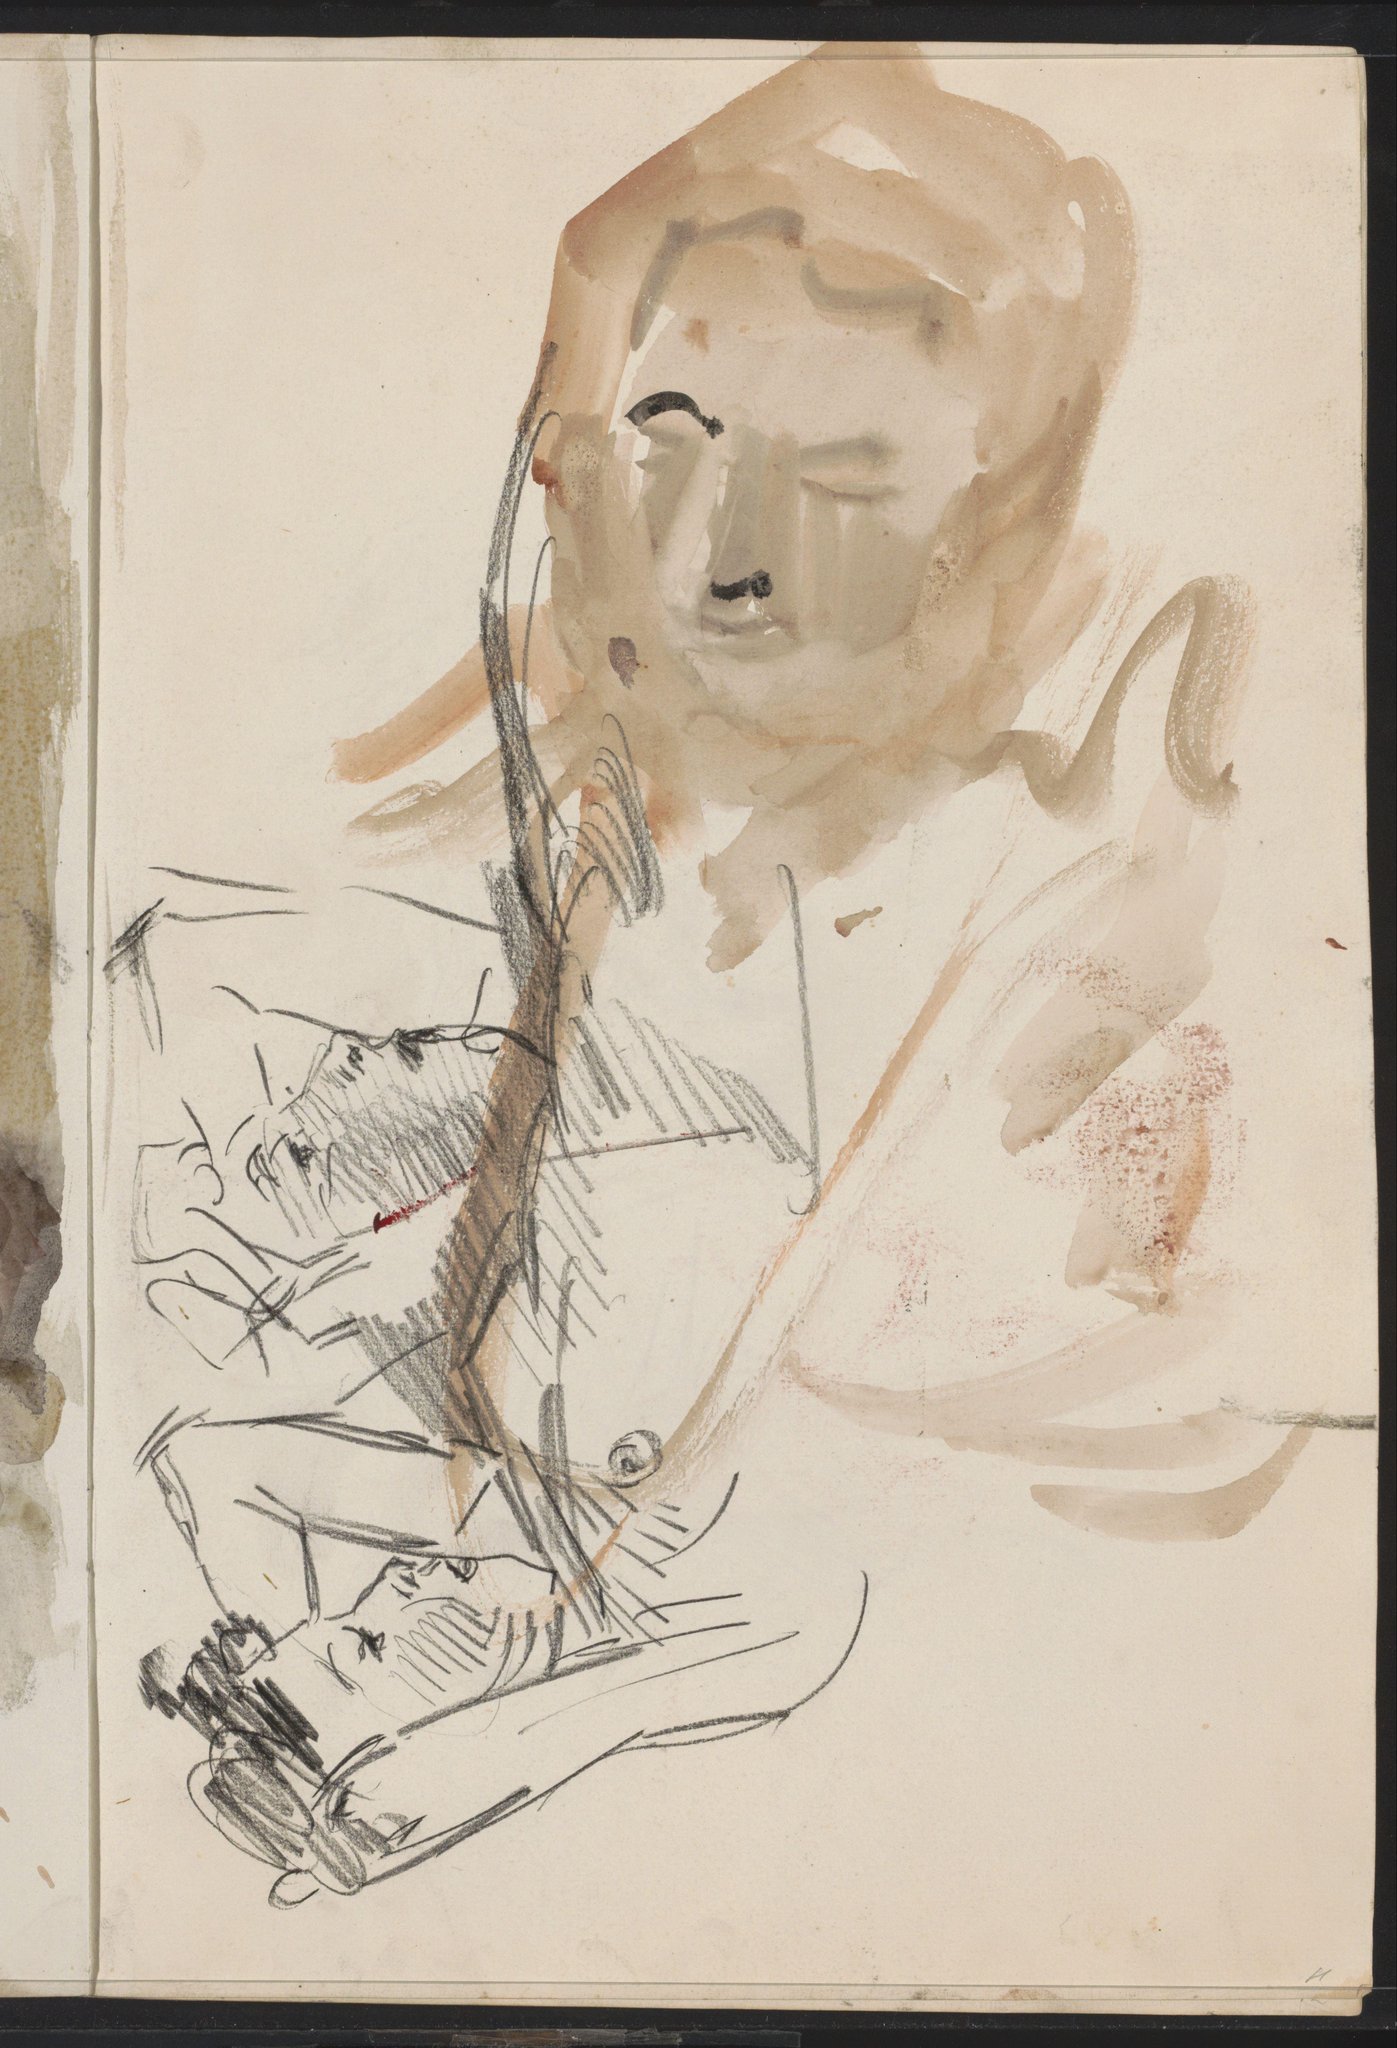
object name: sketchbook leaf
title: Twee liggende vrouwen en een vrouwenhoofd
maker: isaac israels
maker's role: draughtsman, painter, print maker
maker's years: 1865-1934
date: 1875-1934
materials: chalk, paper, watercolor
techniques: brush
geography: the hague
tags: lying on the back with hands under the head - aa - female human figure, head (human) - aa - female human figure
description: De liggende vrouwen zijn naakt. Blad 11 recto uit schetsboek LXIX met 25 bladen.